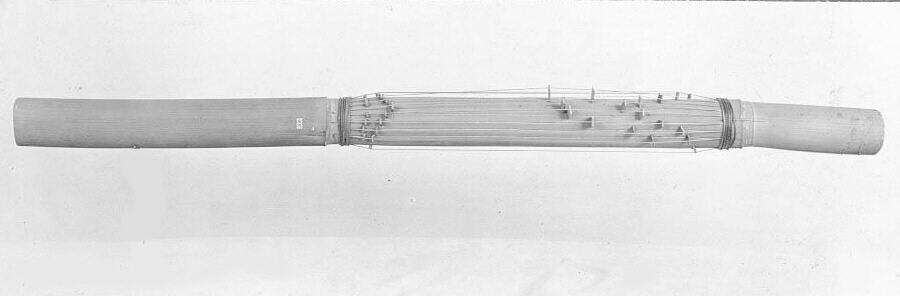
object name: marovany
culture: malagasy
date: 1867-1900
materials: bamboo, wood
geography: madagascar